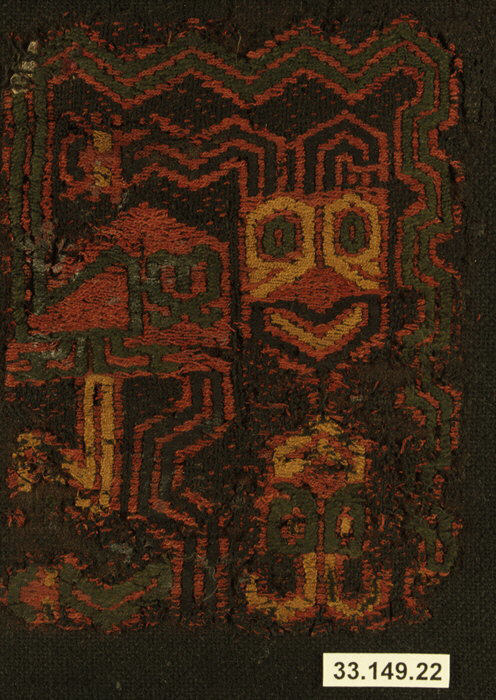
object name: textile fragment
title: Embroidered Fragment with Figures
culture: paracas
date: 500-101 BCE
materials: animal fiber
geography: peru